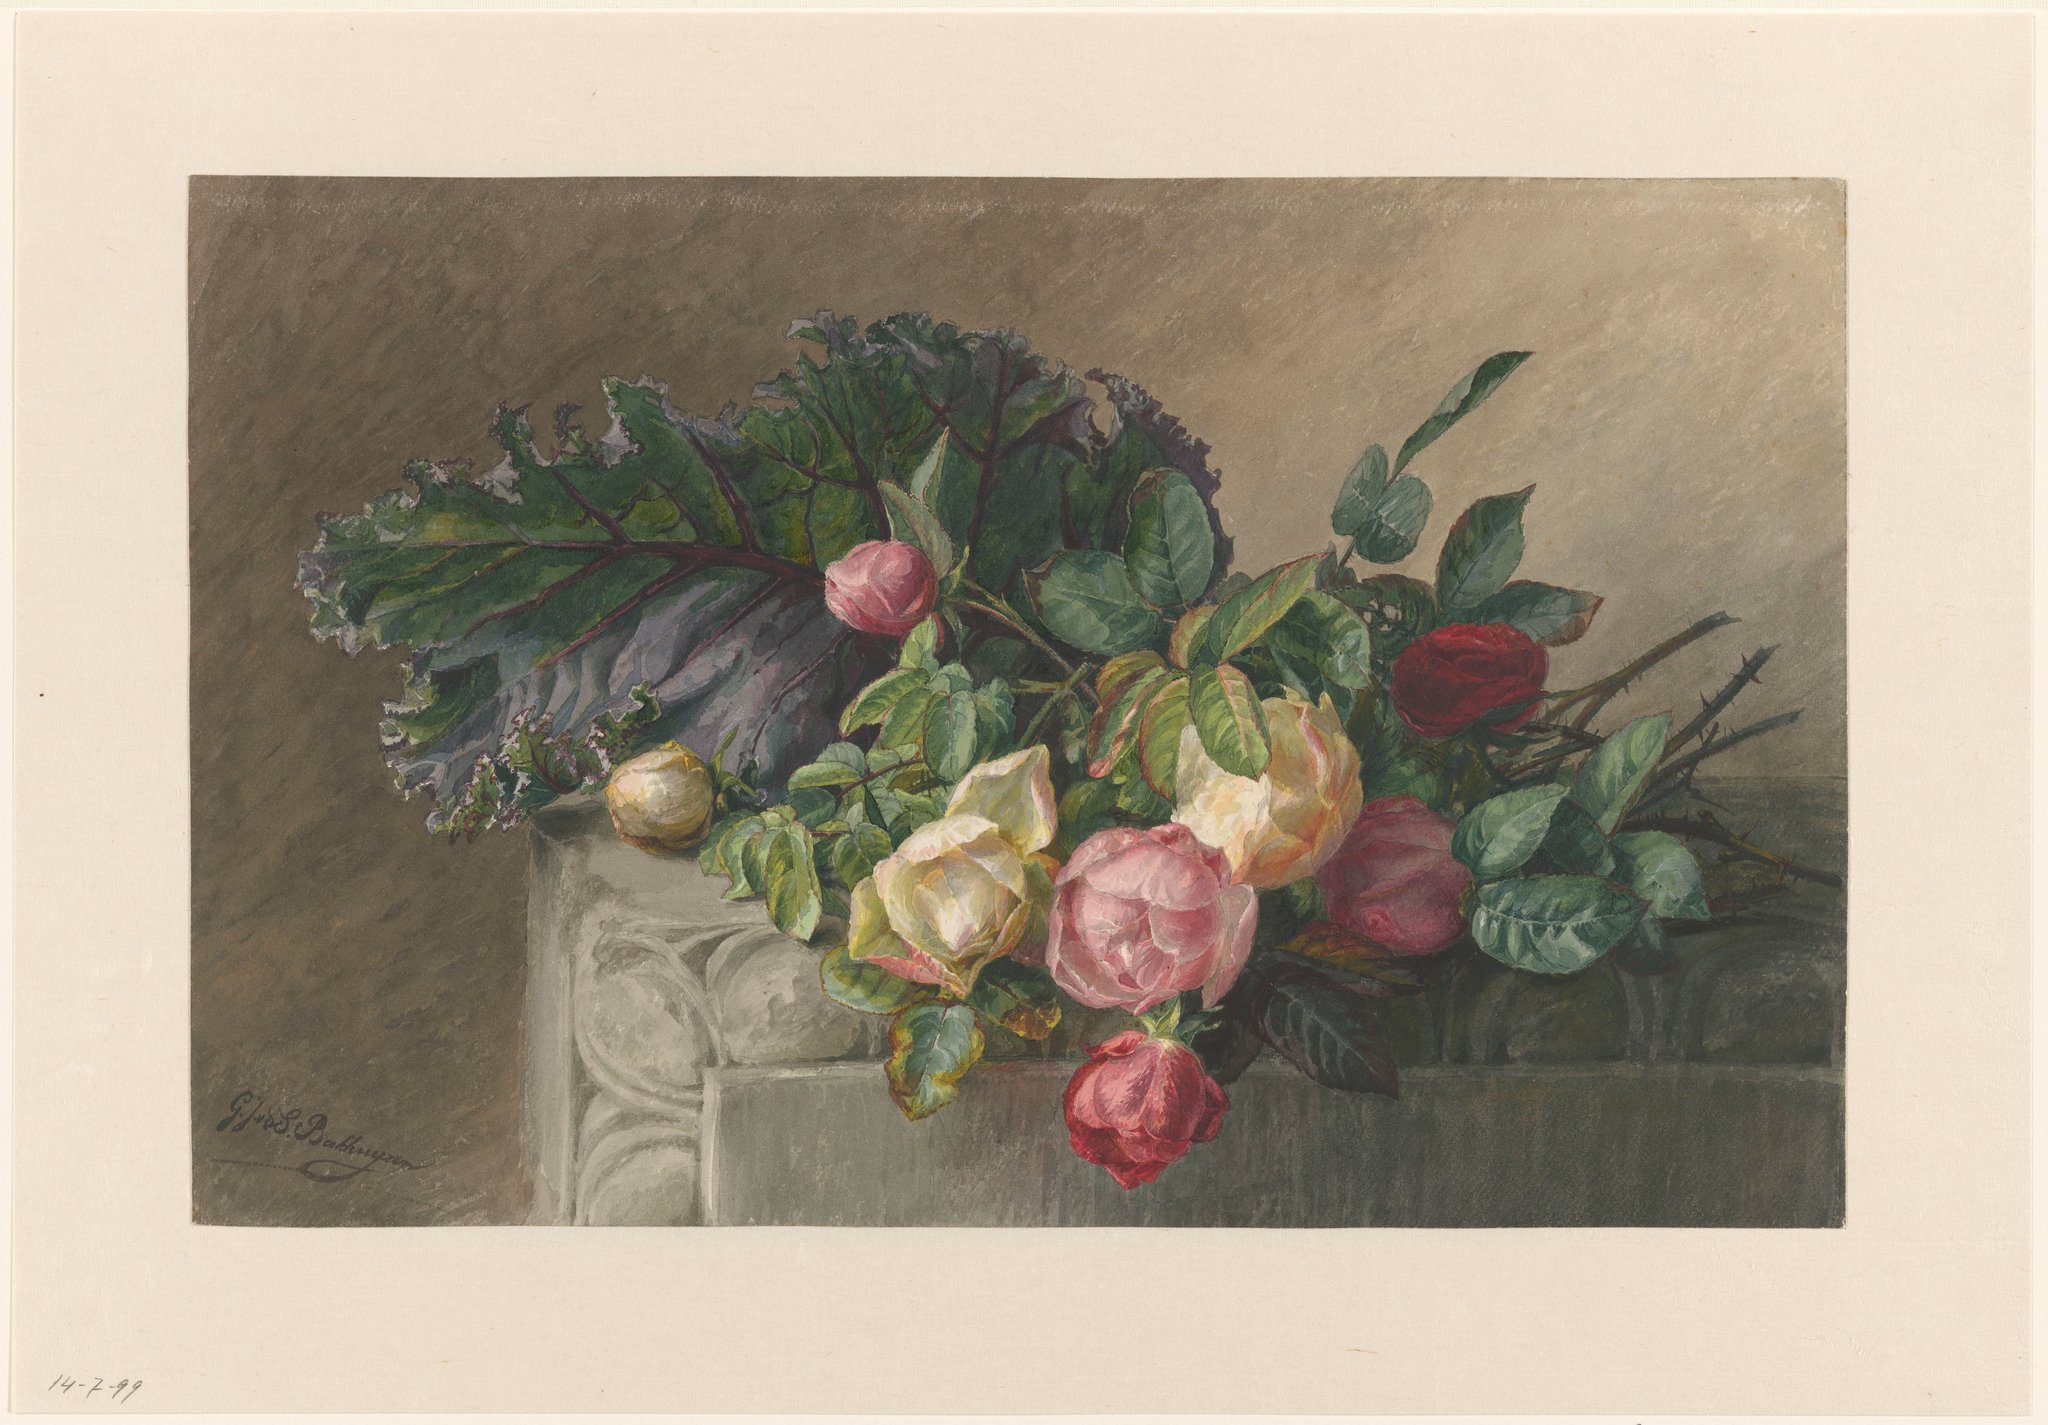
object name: drawing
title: Stilleven met rozen en koolblad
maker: gerardine jacoba van de sande bakhuyzen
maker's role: draughtsman, painter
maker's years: 1826-1895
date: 1836-1892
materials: paper, pencil, watercolor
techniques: brush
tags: cut flowers; nosegay, bunch of flowers, flowers: rose